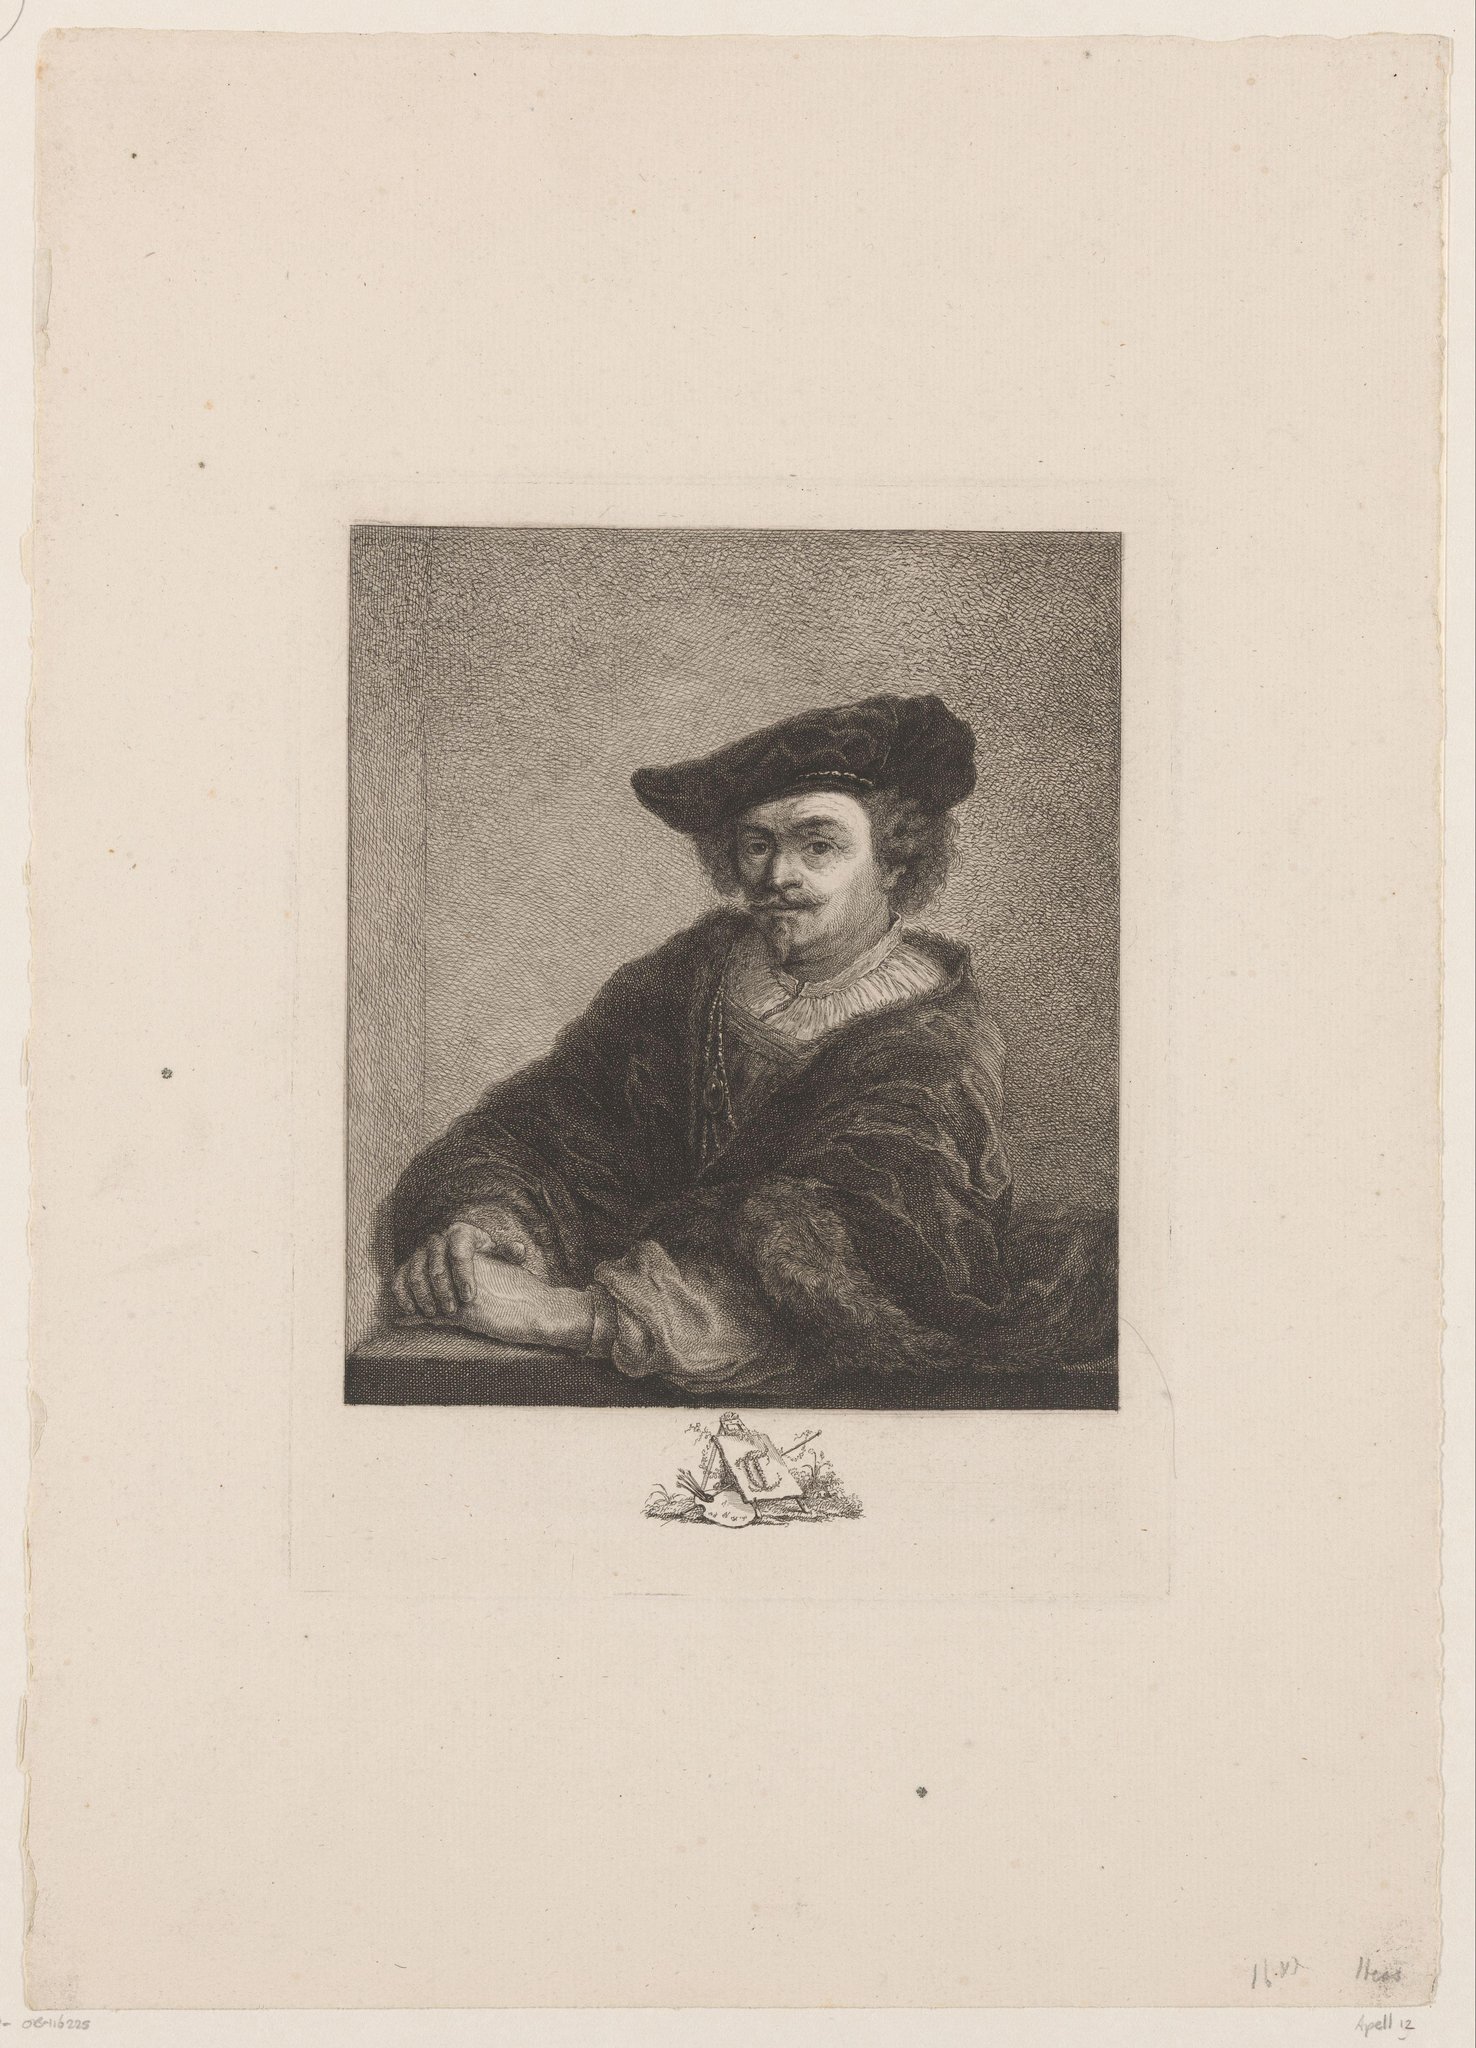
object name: print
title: Portret van Govert Flinck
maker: carl ernst christoph hess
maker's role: print maker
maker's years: 1755-1828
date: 1765-1828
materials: paper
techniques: etching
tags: cleves, amsterdam, govert flinck, the liberal arts, 'artes liberales', historical persons, portrait, self-portrait of painter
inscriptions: collector's mark: Lugt 240